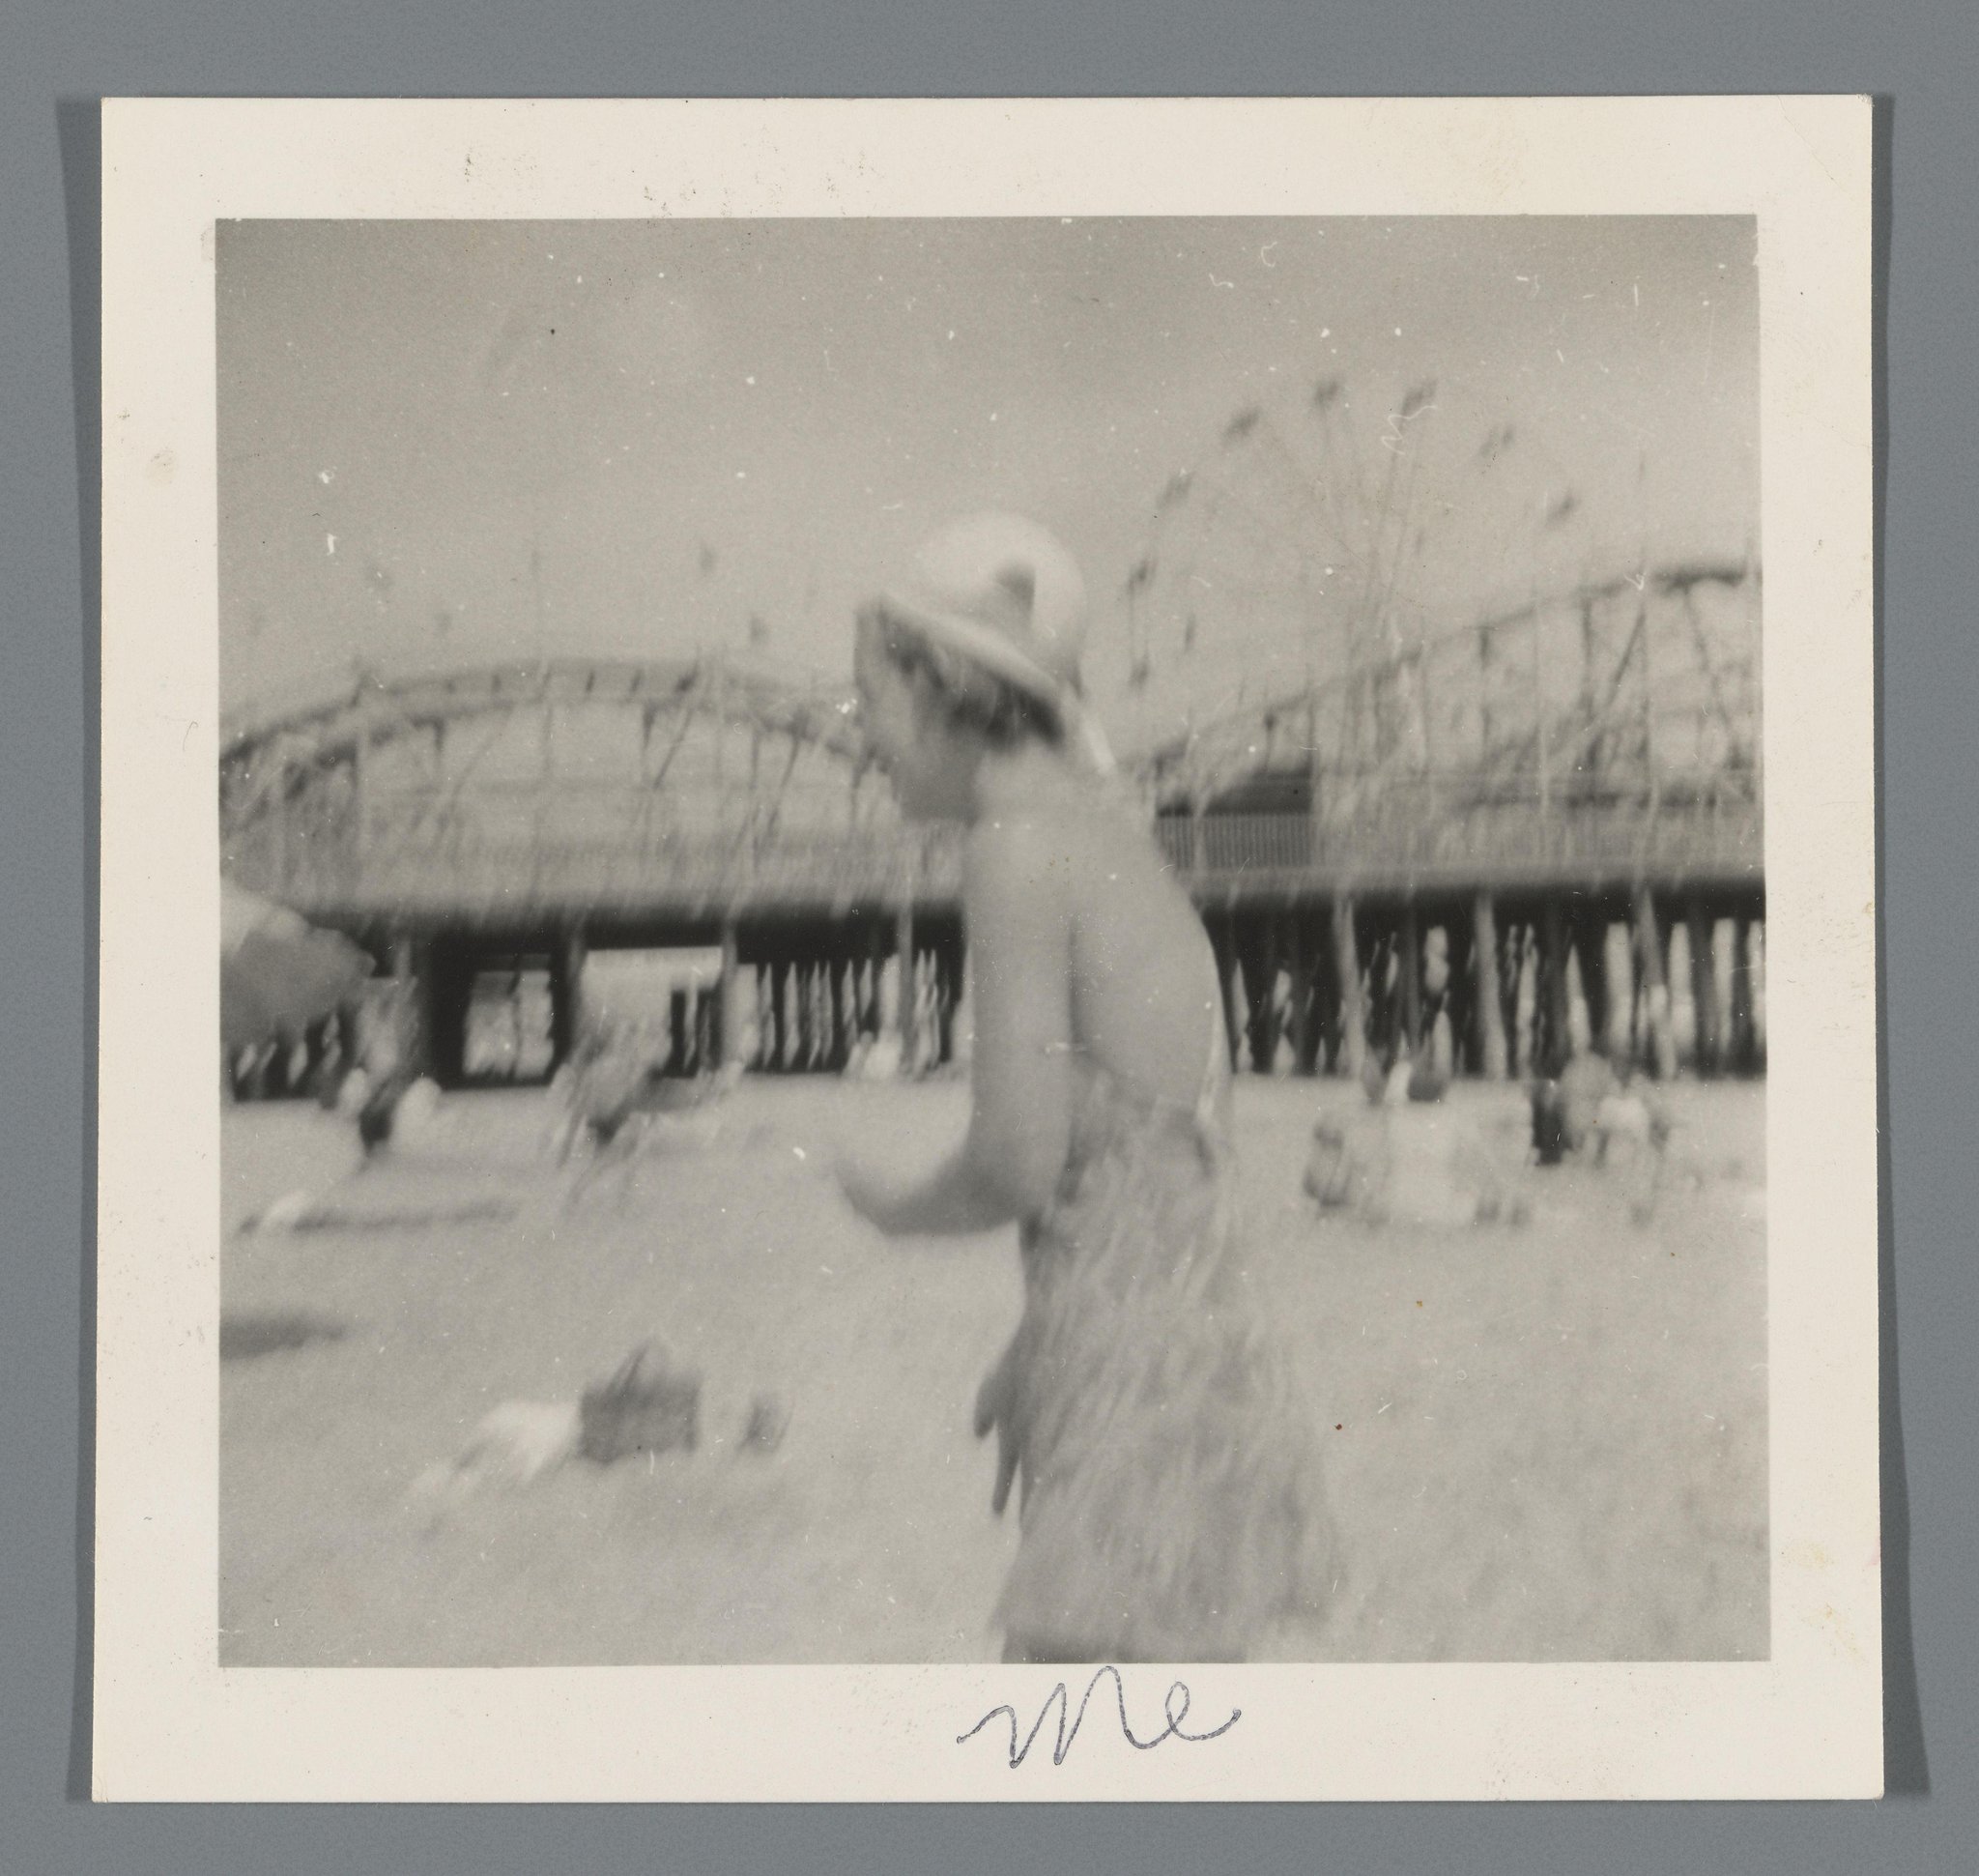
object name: photograph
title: Vrouw op strand voor een pretpark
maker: Anonymous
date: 1935-1950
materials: paper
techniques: gelatin silver print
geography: united states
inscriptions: inscription: ‘Me’, stamp: ‘475’